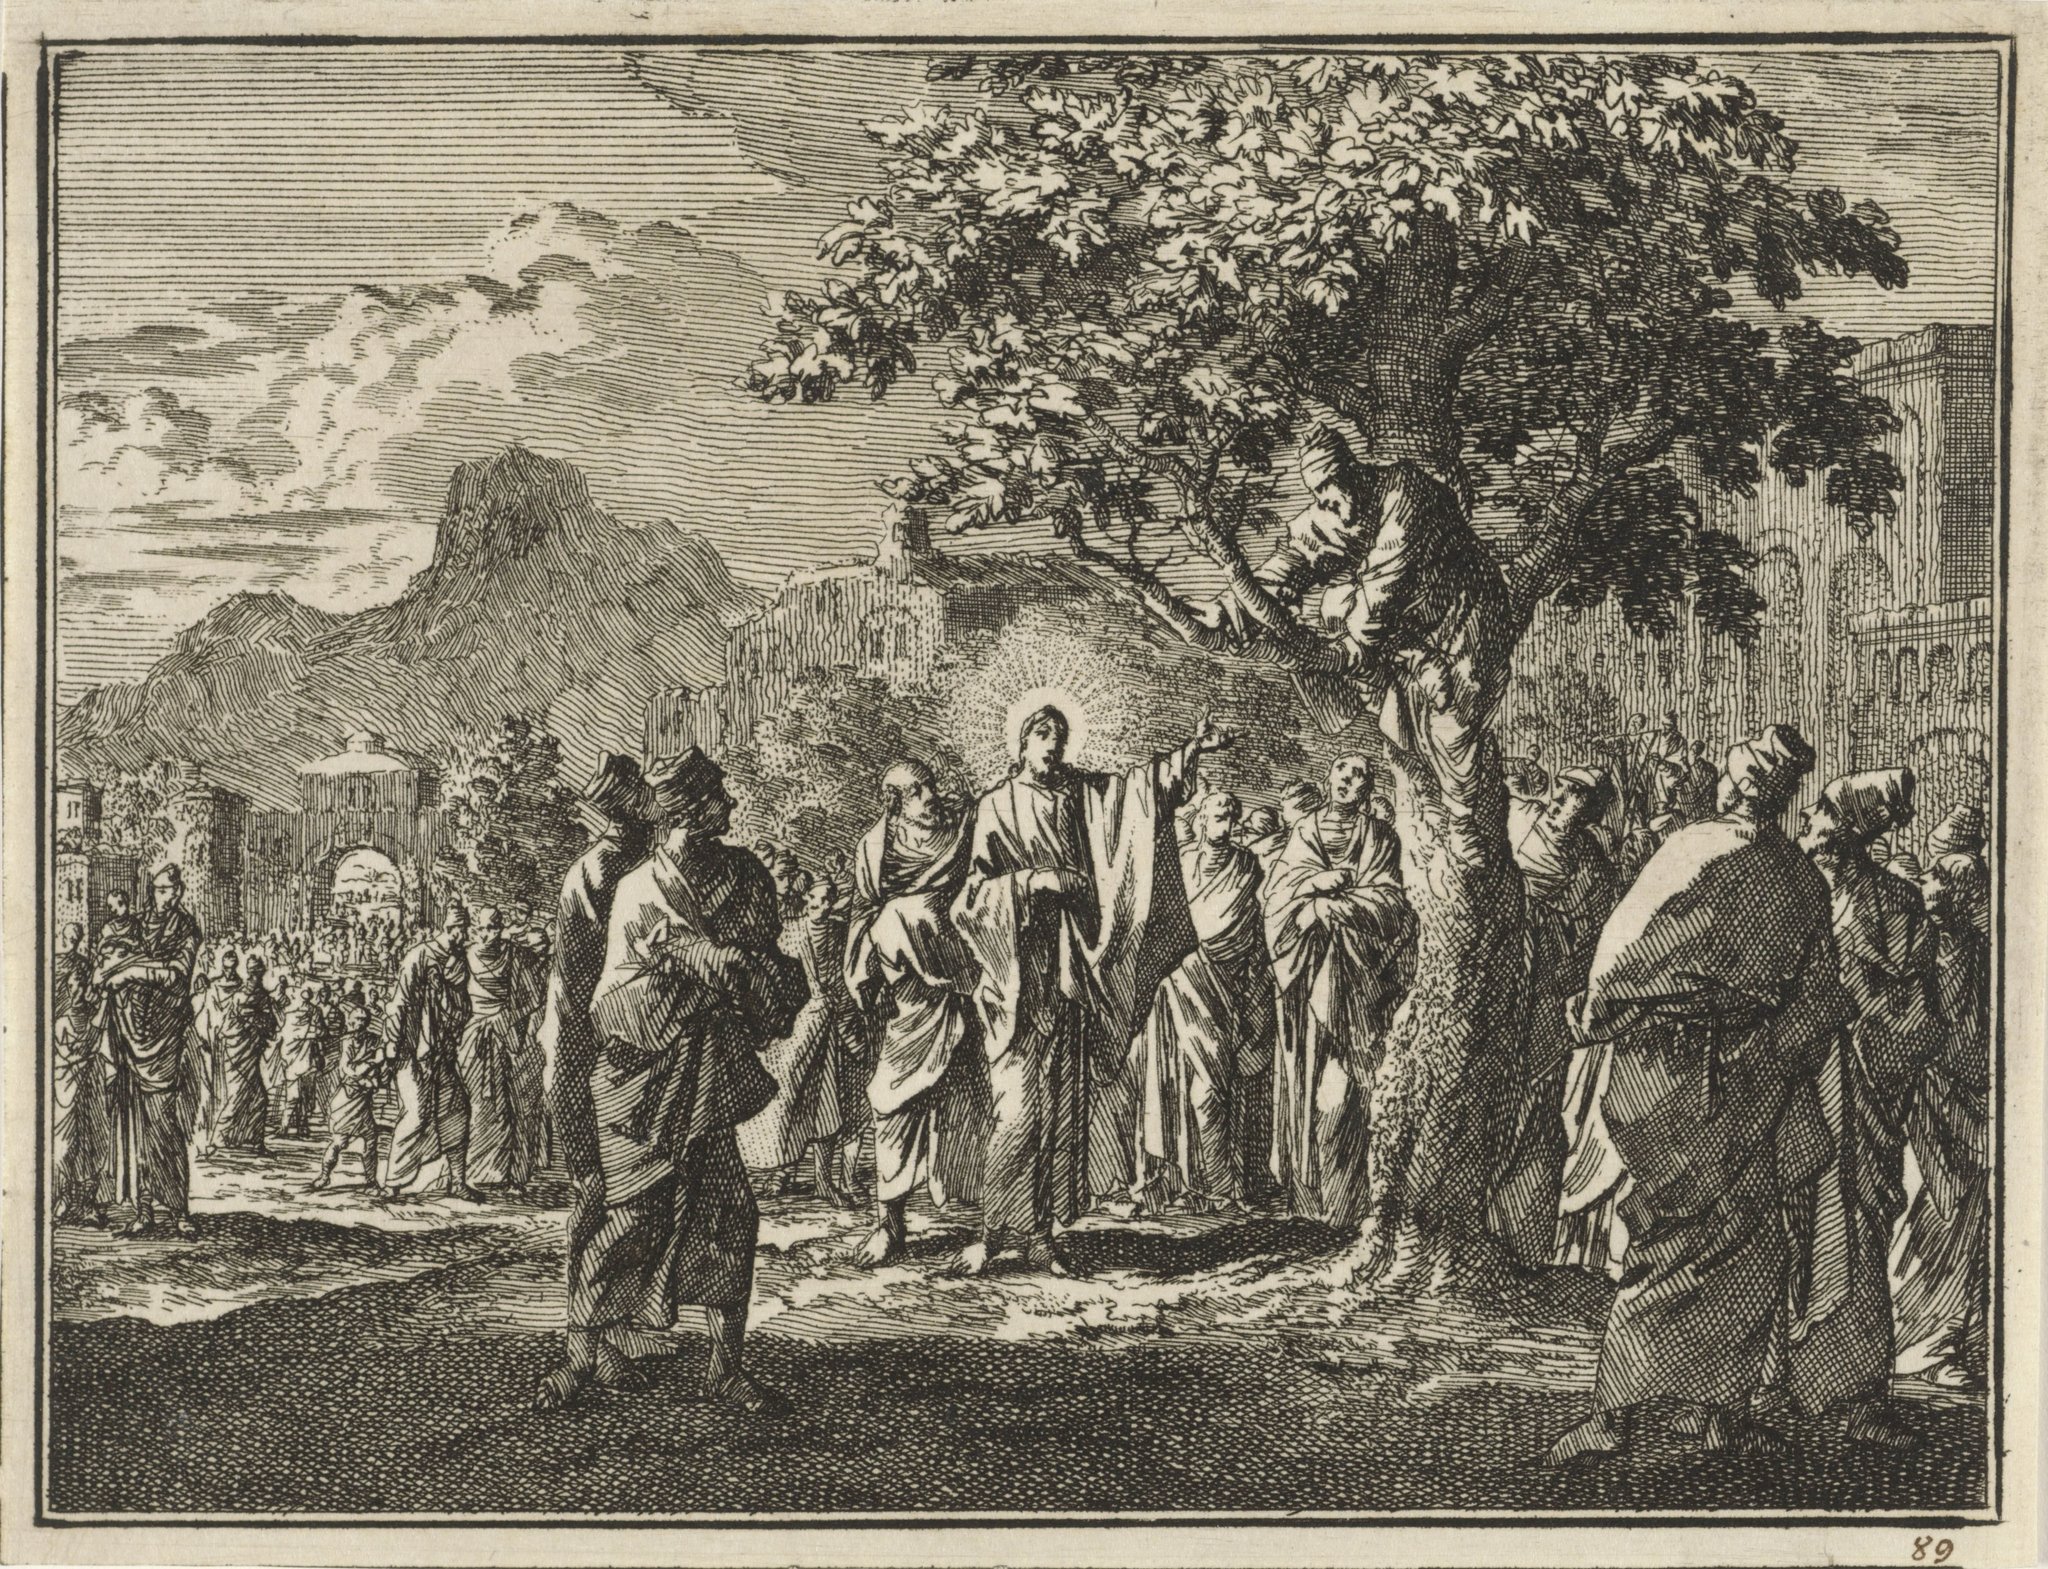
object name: print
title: Zacheüs in de vijgenboom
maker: jan luyken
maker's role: draughtsman, print maker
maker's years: 1649-1712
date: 1712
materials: paper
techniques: etching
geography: amsterdam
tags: calling of zacchaeus, who is sitting in a fig-tree (christ passing through jericho)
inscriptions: collector's mark: Lugt 2228, number: ‘89’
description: Proefdruk van illustratie uit: Luyken, Jan. De schriftuurlyke geschiedenissen en gelykenissen van het Oude en Nieuwe Verbond, 2 delen. Amsterdam: Wed. Pieter Arentsz II en Cornelis van der Sys, 1712, dl. II.